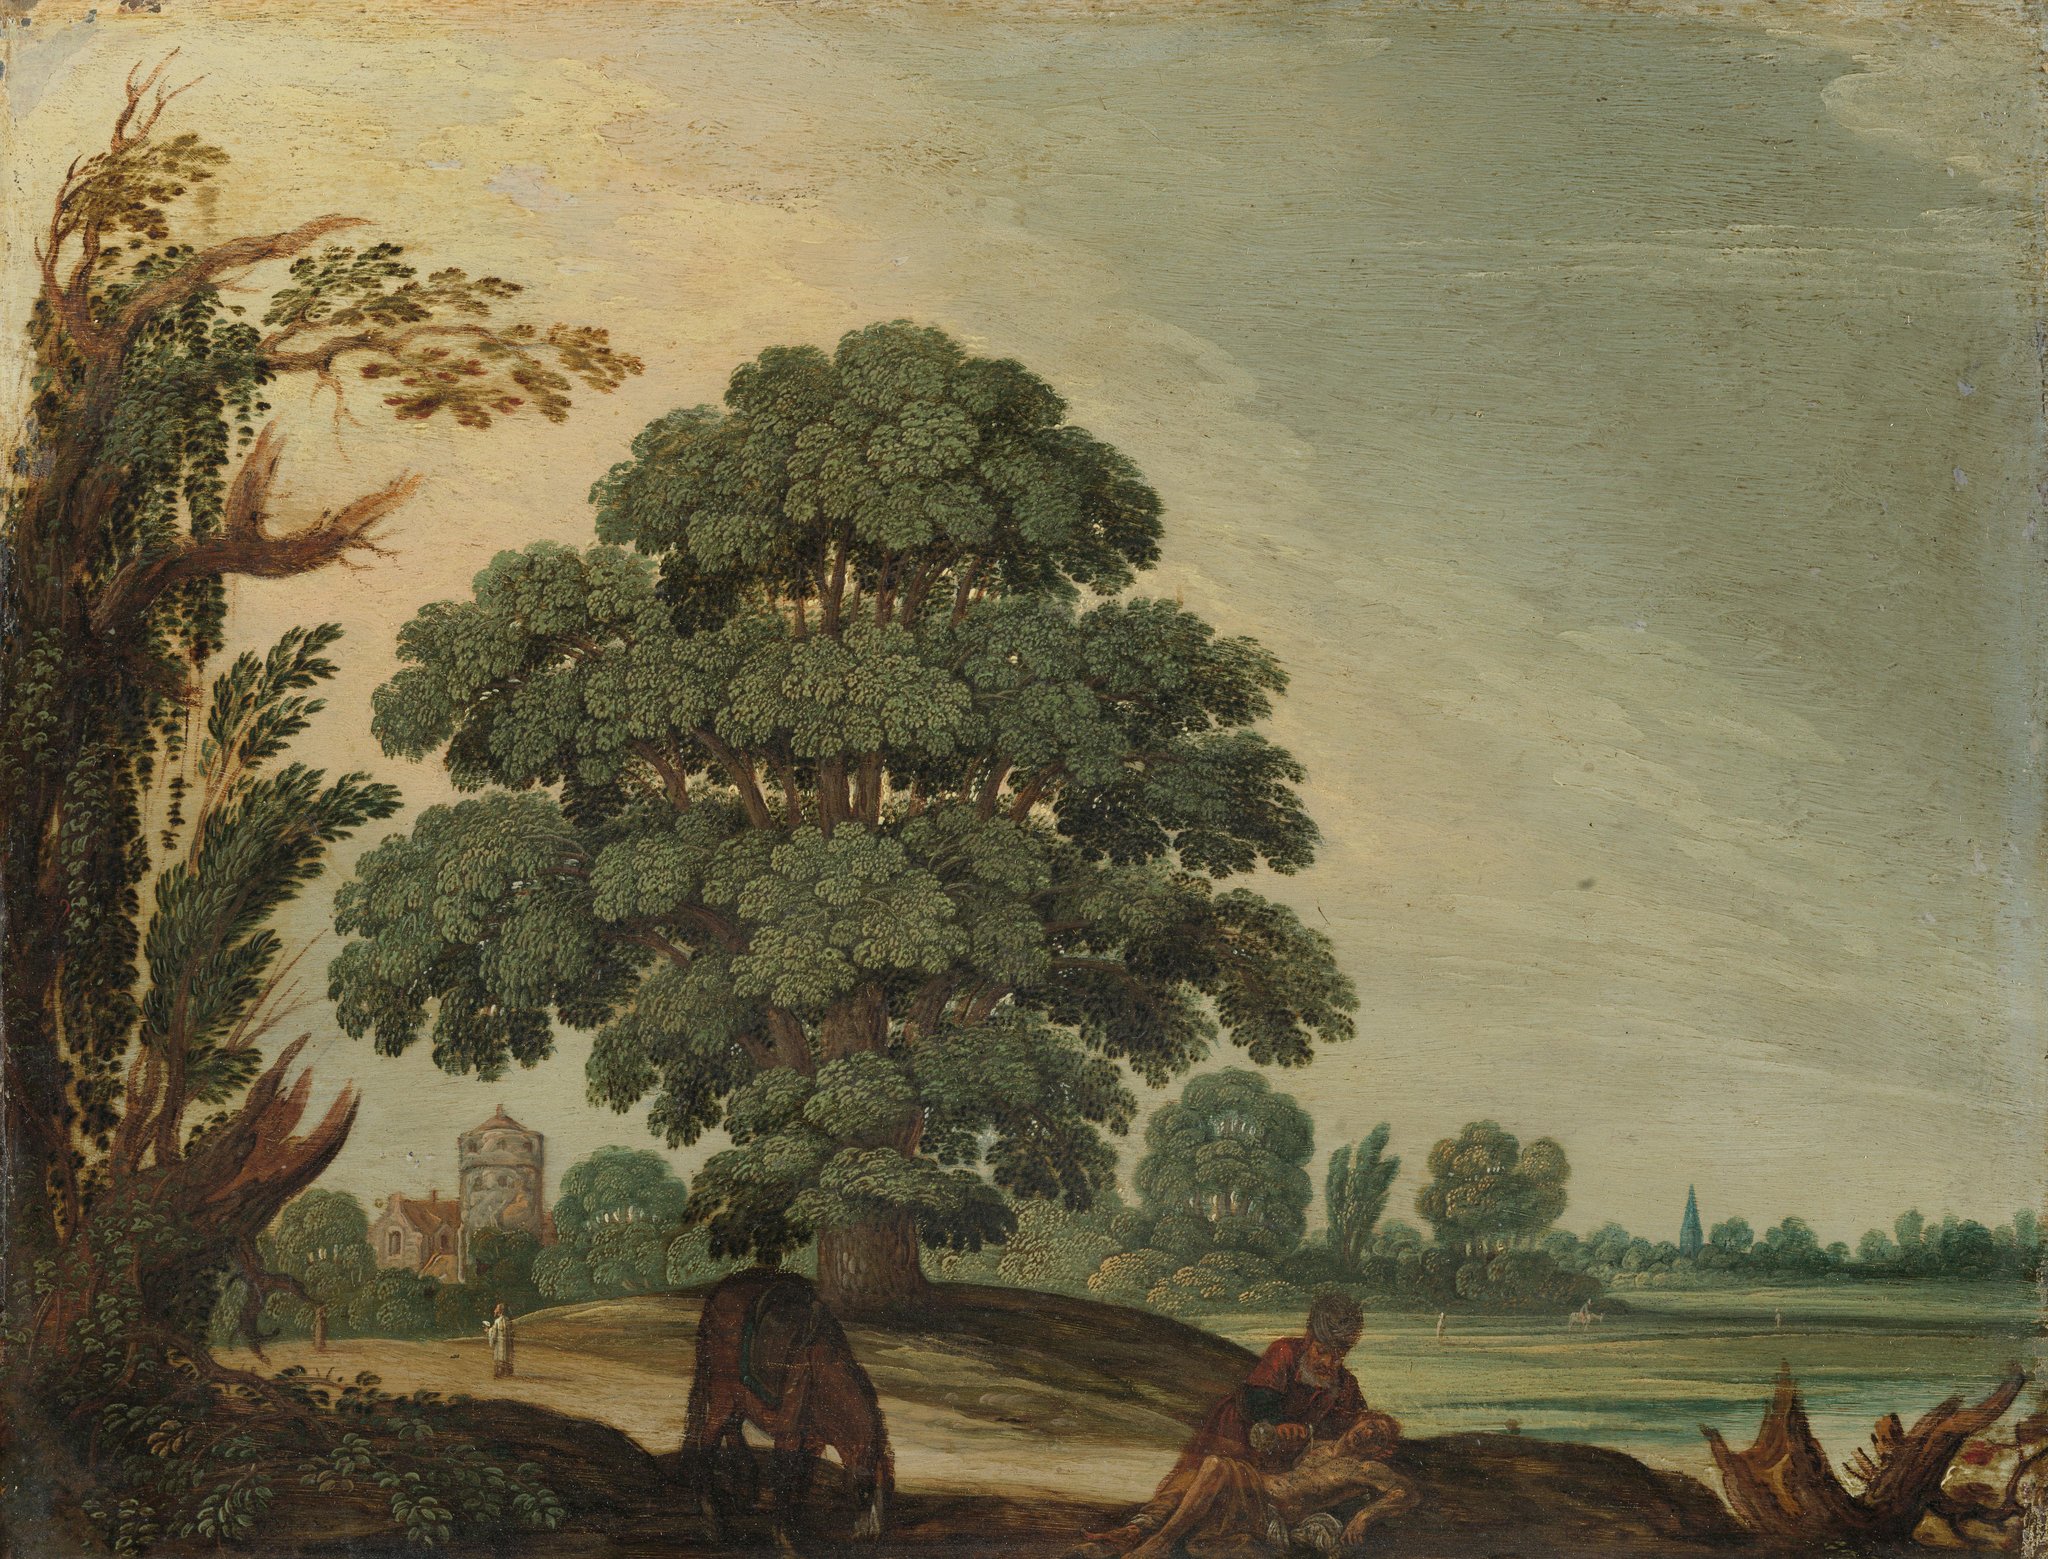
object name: painting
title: Landscape with the Good Samaritan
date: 1600-1660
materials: copper, oil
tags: a samaritan tending the wounds of the traveller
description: Landschap met de barmhartige Samaritaan die de wonden van de overvallen man verzorgt. In het midden een grote boom, links en rechts in het verschiet gebouwen.